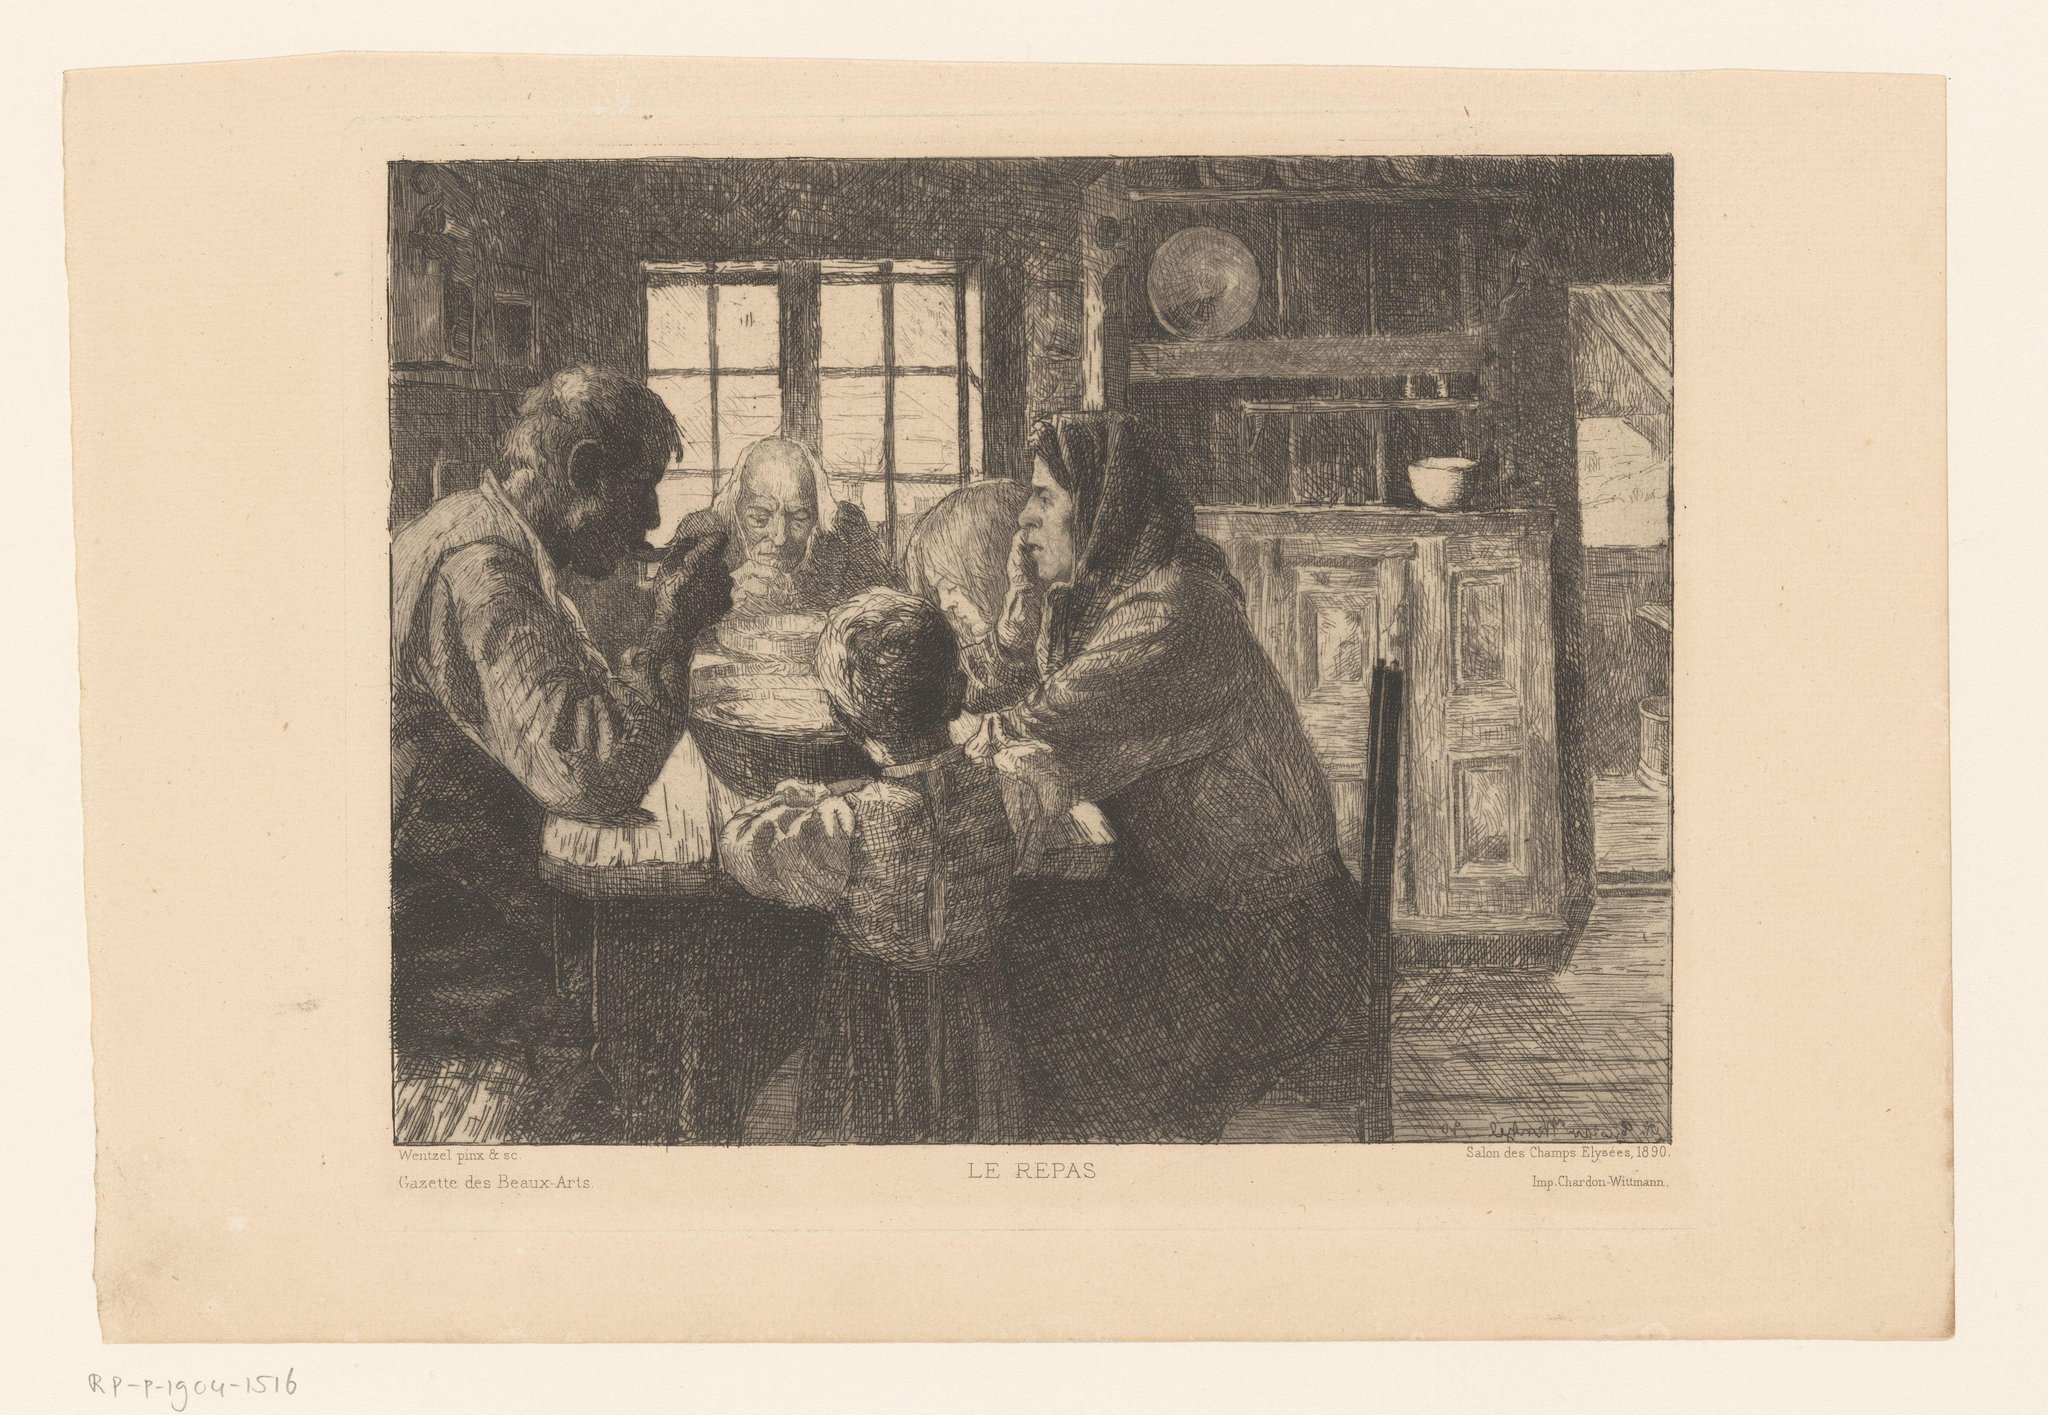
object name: print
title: De maaltijd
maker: nils gustav wentzel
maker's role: print maker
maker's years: 1859-1927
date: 1890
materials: paper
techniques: etching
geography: paris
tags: (family) meal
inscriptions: collector's mark: Lugt 2228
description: Interieur met een gezin aan de maaltijd.